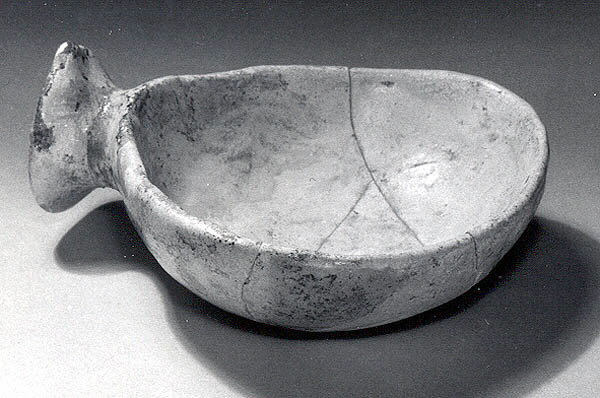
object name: scoop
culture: iranian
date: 900-801 BCE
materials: faience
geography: iran